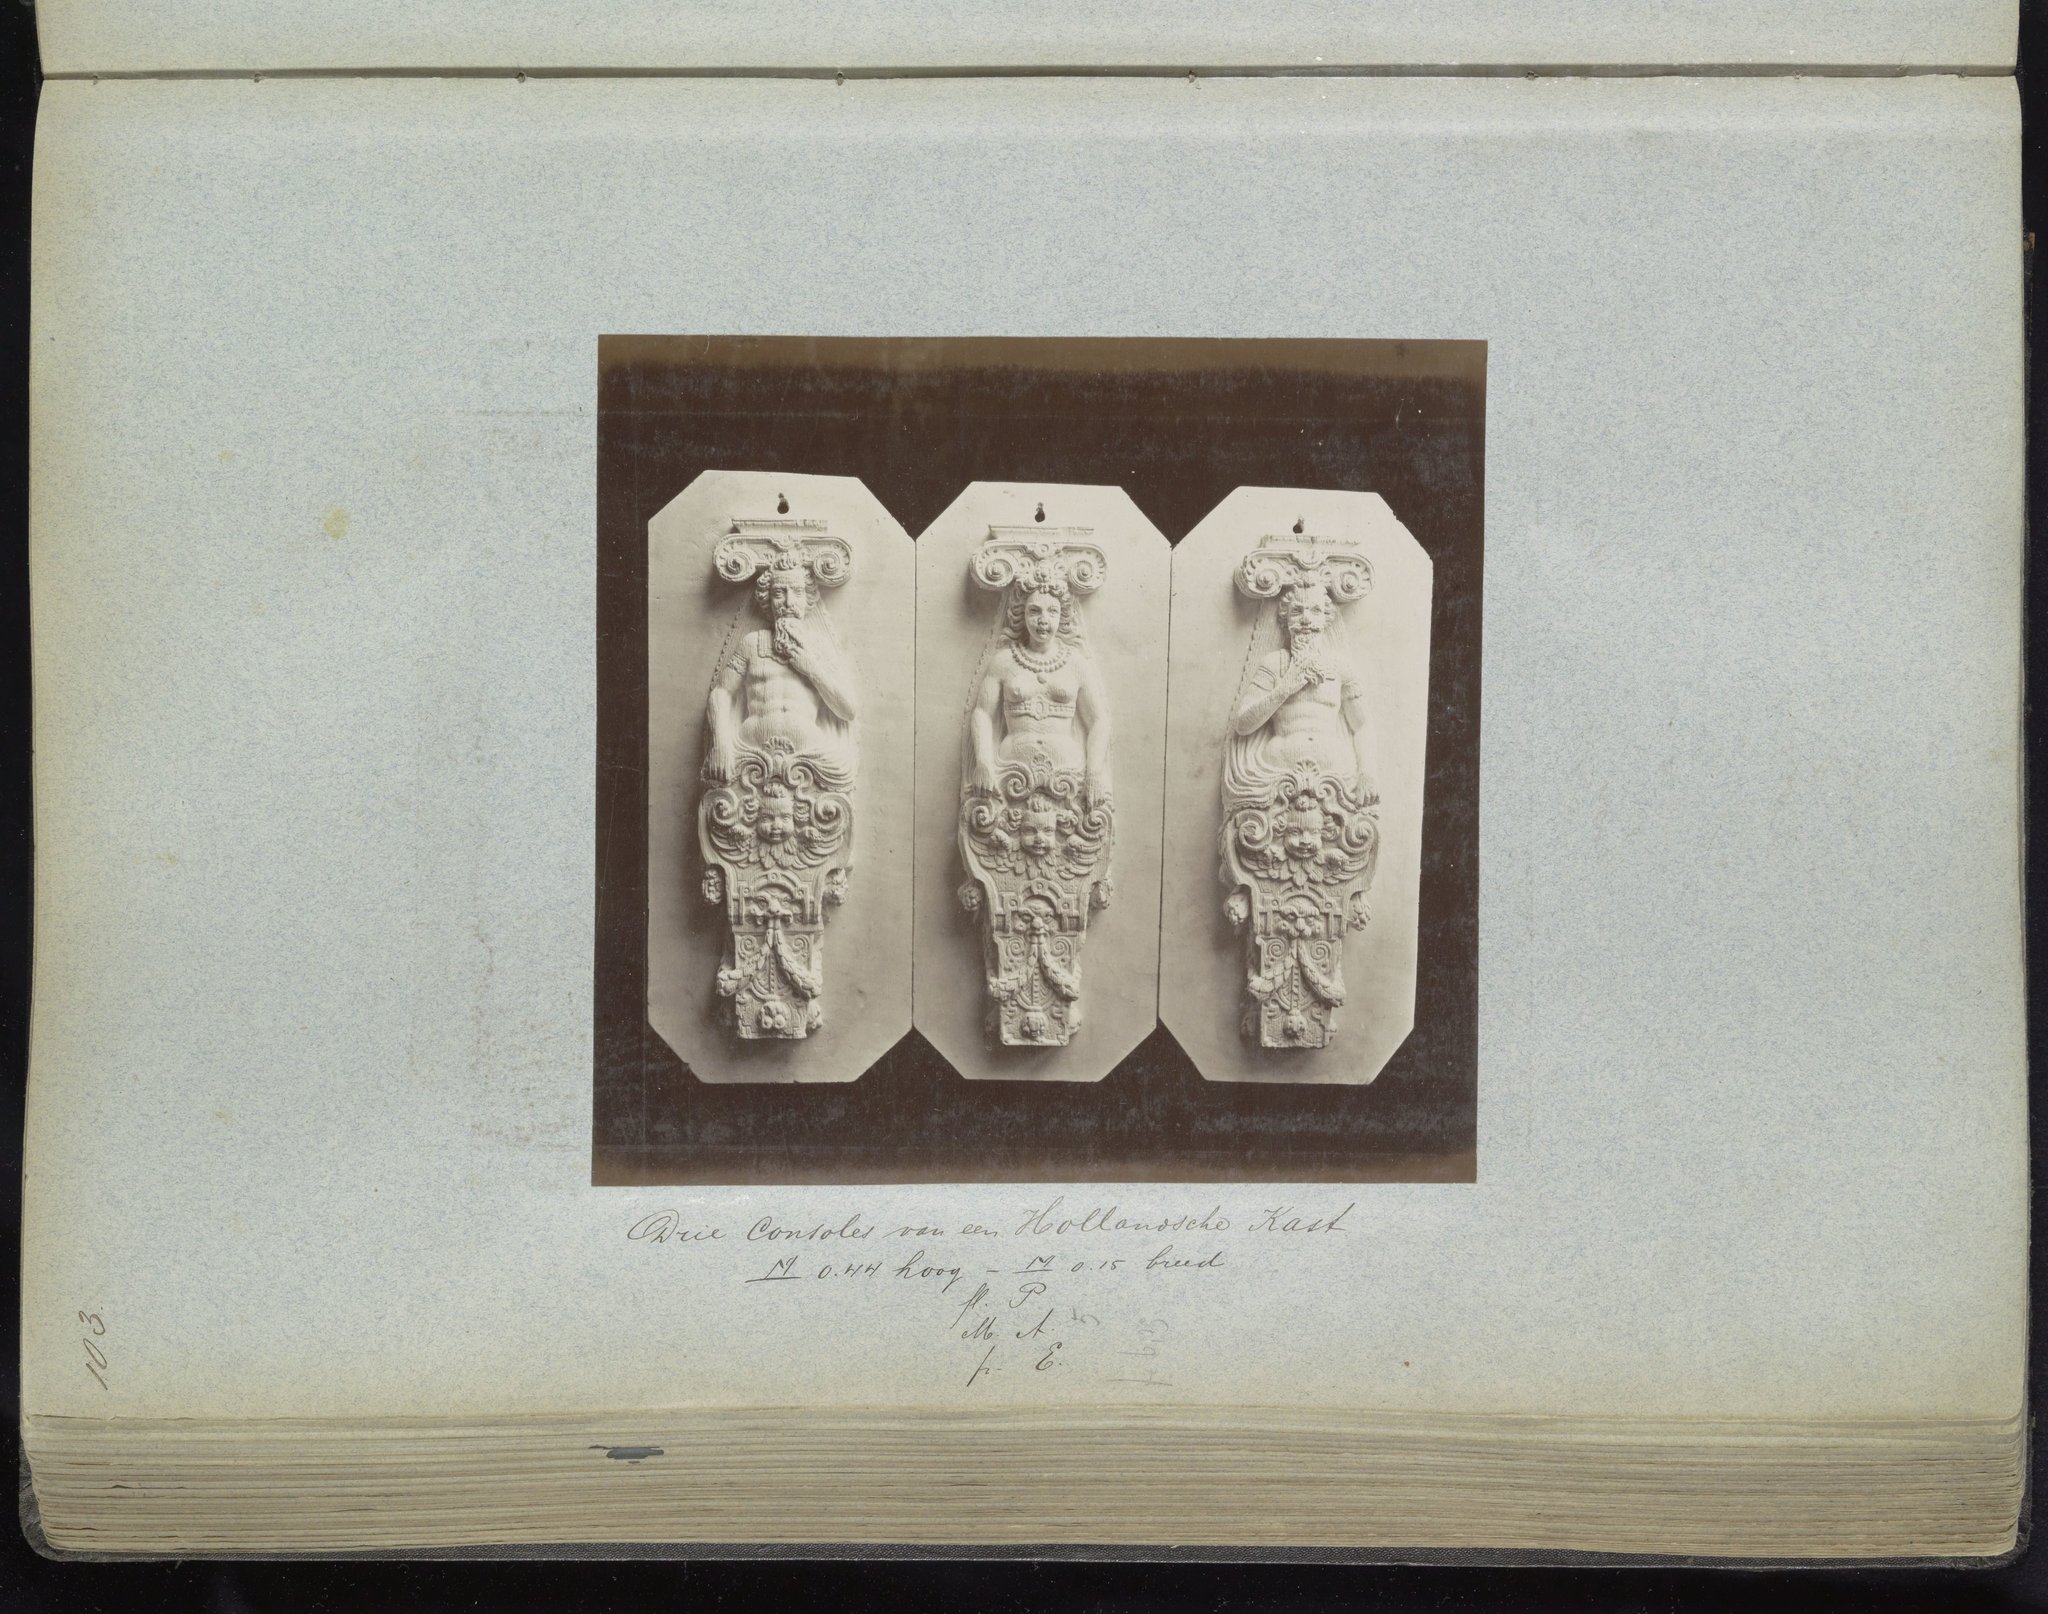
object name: album leaf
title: Drie gipsen afgietsels van consoles van een Hollandse kast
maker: Anonymous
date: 1875-1900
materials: paper, photographic support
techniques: albumen print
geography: netherlands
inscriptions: annotation, annotation: ‘Drie consoles van een Hollandsche kast / M 0.44 hoog - 0.51 breed’